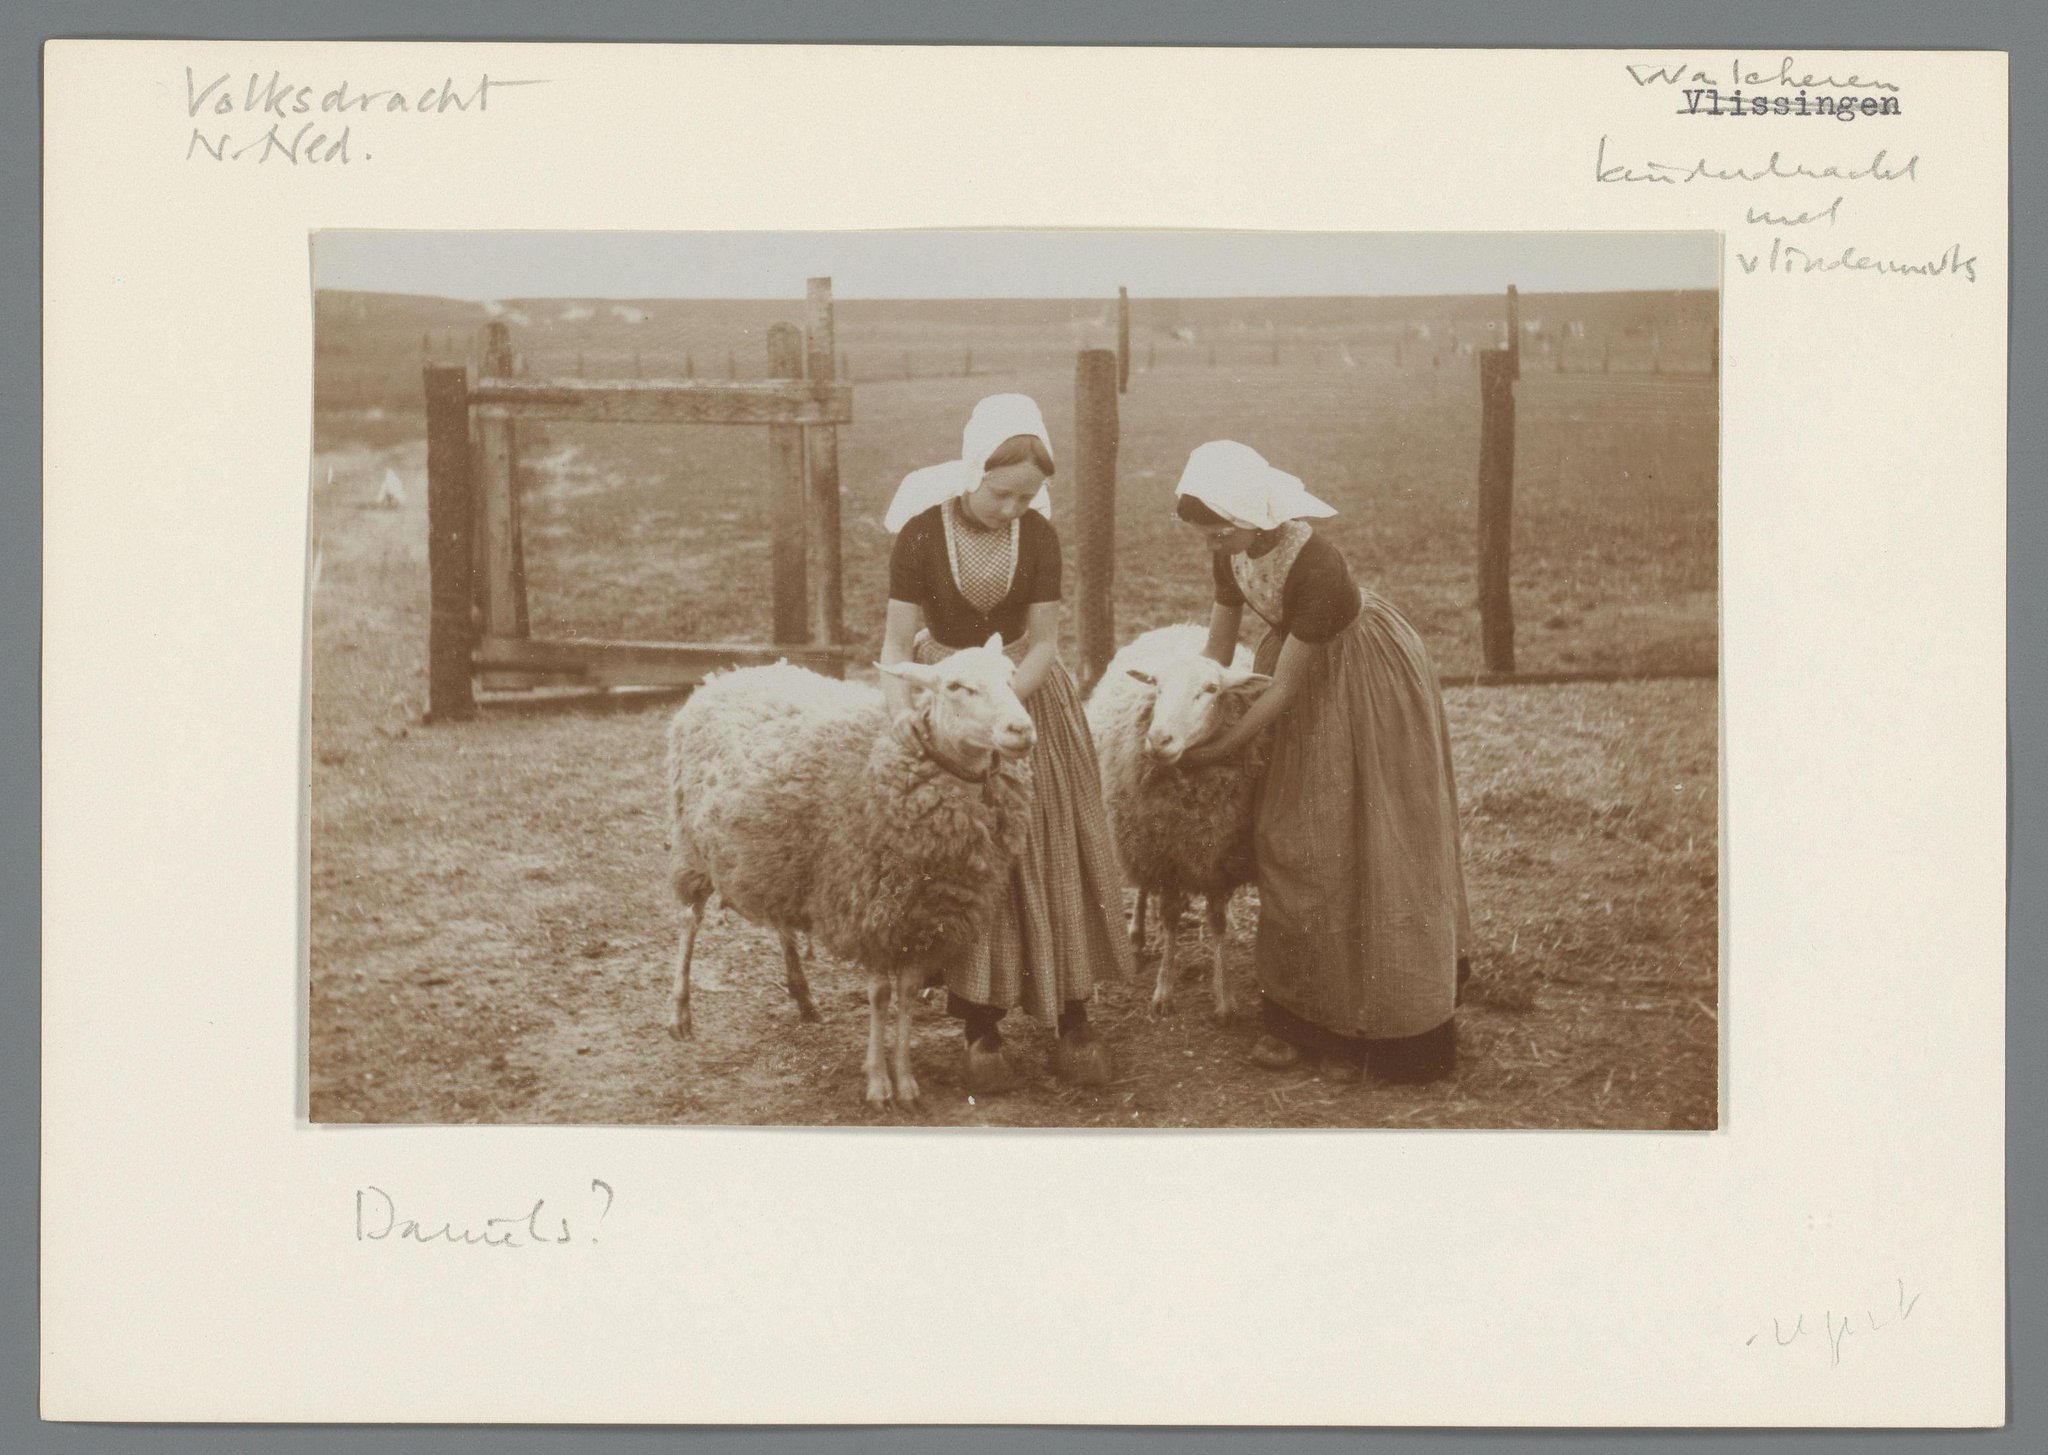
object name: photograph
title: Twee meisjes in Walcherse dracht en twee schapen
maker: Anonymous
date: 1880-1920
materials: paper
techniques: collodion silver print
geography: walcheren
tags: historical persons, folk costume, regional costume, shearing (sheep)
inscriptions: number: ‘- 527078’, inscription: ‘Volksdracht/ N.Ned./ Walcheren/ kinderdracht/ met/ vlindermuts/ Daniels?’, number: ‘32.836’